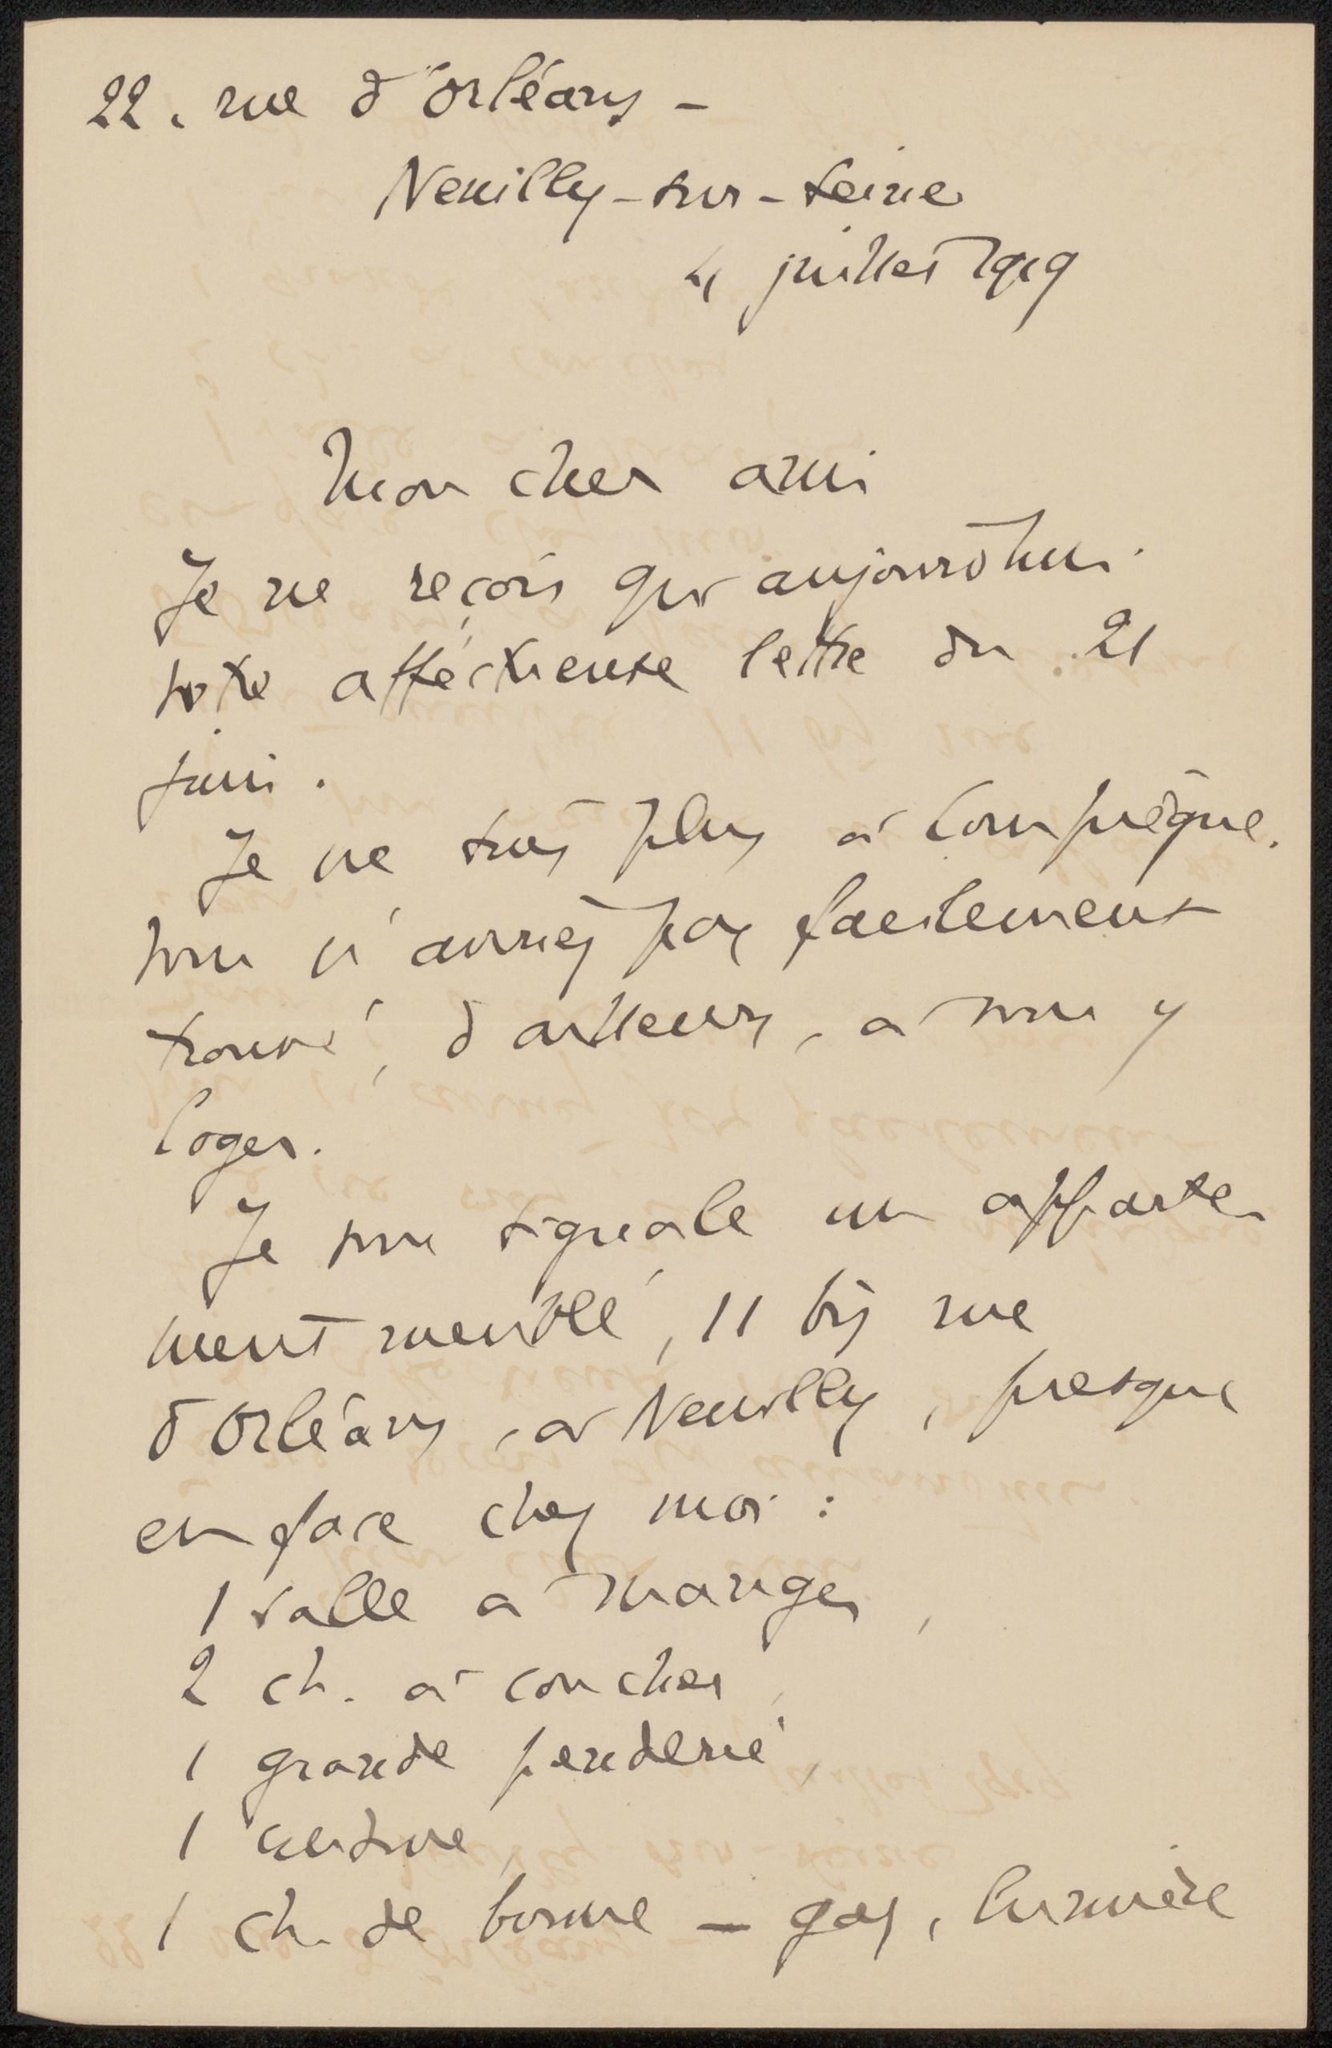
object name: letter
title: Brief aan Philip Zilcken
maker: gabriel mourey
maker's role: criticus, schrijver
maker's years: 1865-1943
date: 1919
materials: ink, paper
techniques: pen, writing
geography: neuilly-sur-seine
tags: the hague, painter, draughtsman, philip zilcken, money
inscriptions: collector's mark: ‘RPK’